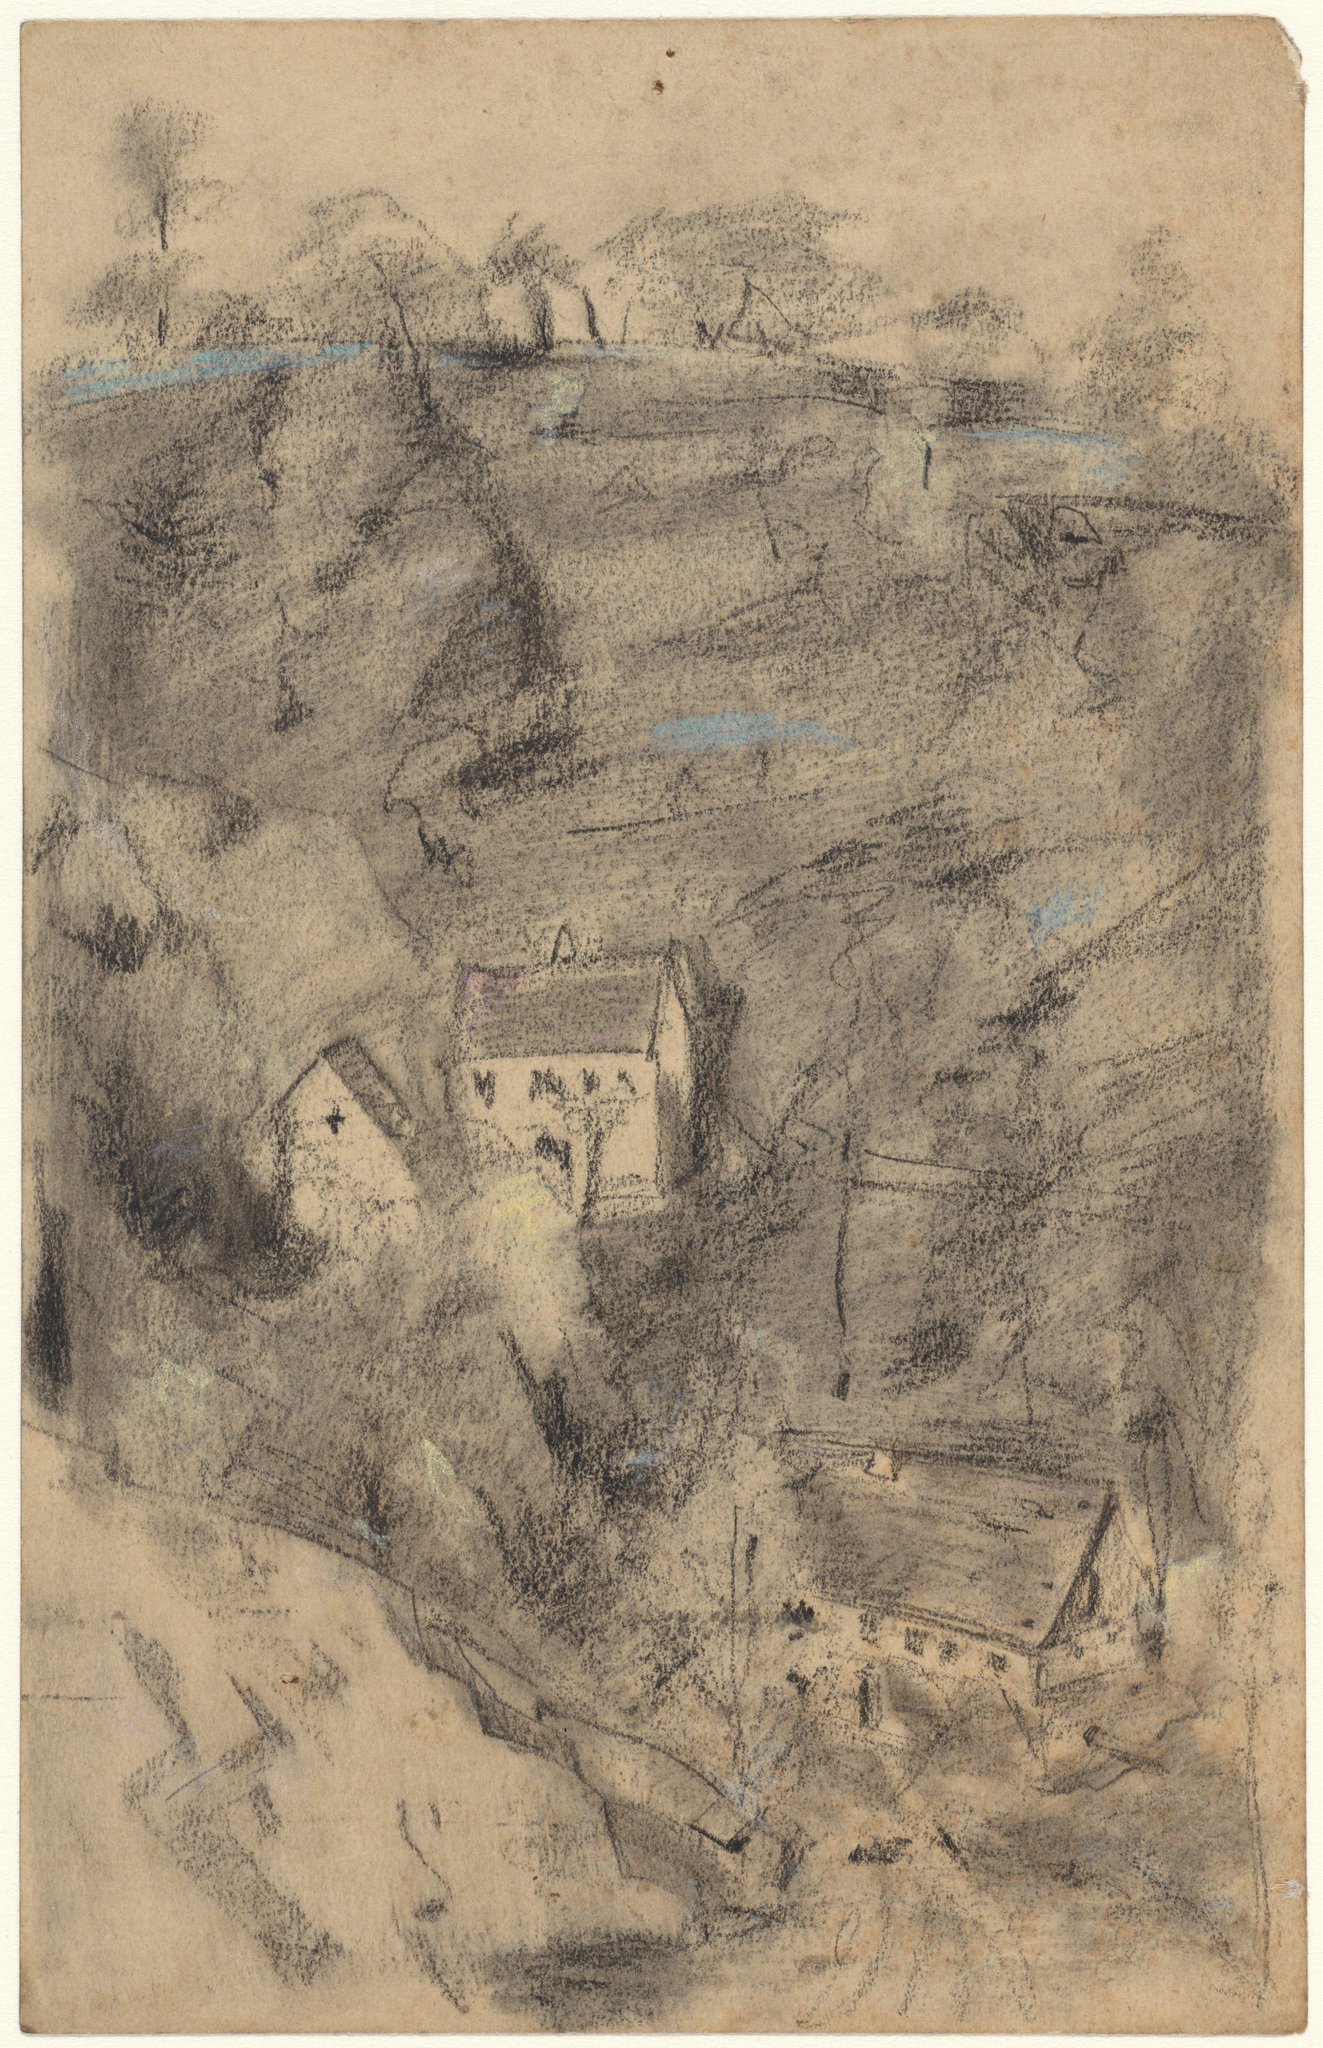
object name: drawing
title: Huizen tegen een berg bij Dresden (Wachwitz?)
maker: theo nieuwenhuis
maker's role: designer, draughtsman, print maker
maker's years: 1866-1951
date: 1888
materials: chalk, paper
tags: farm or solitary house in landscape, germany